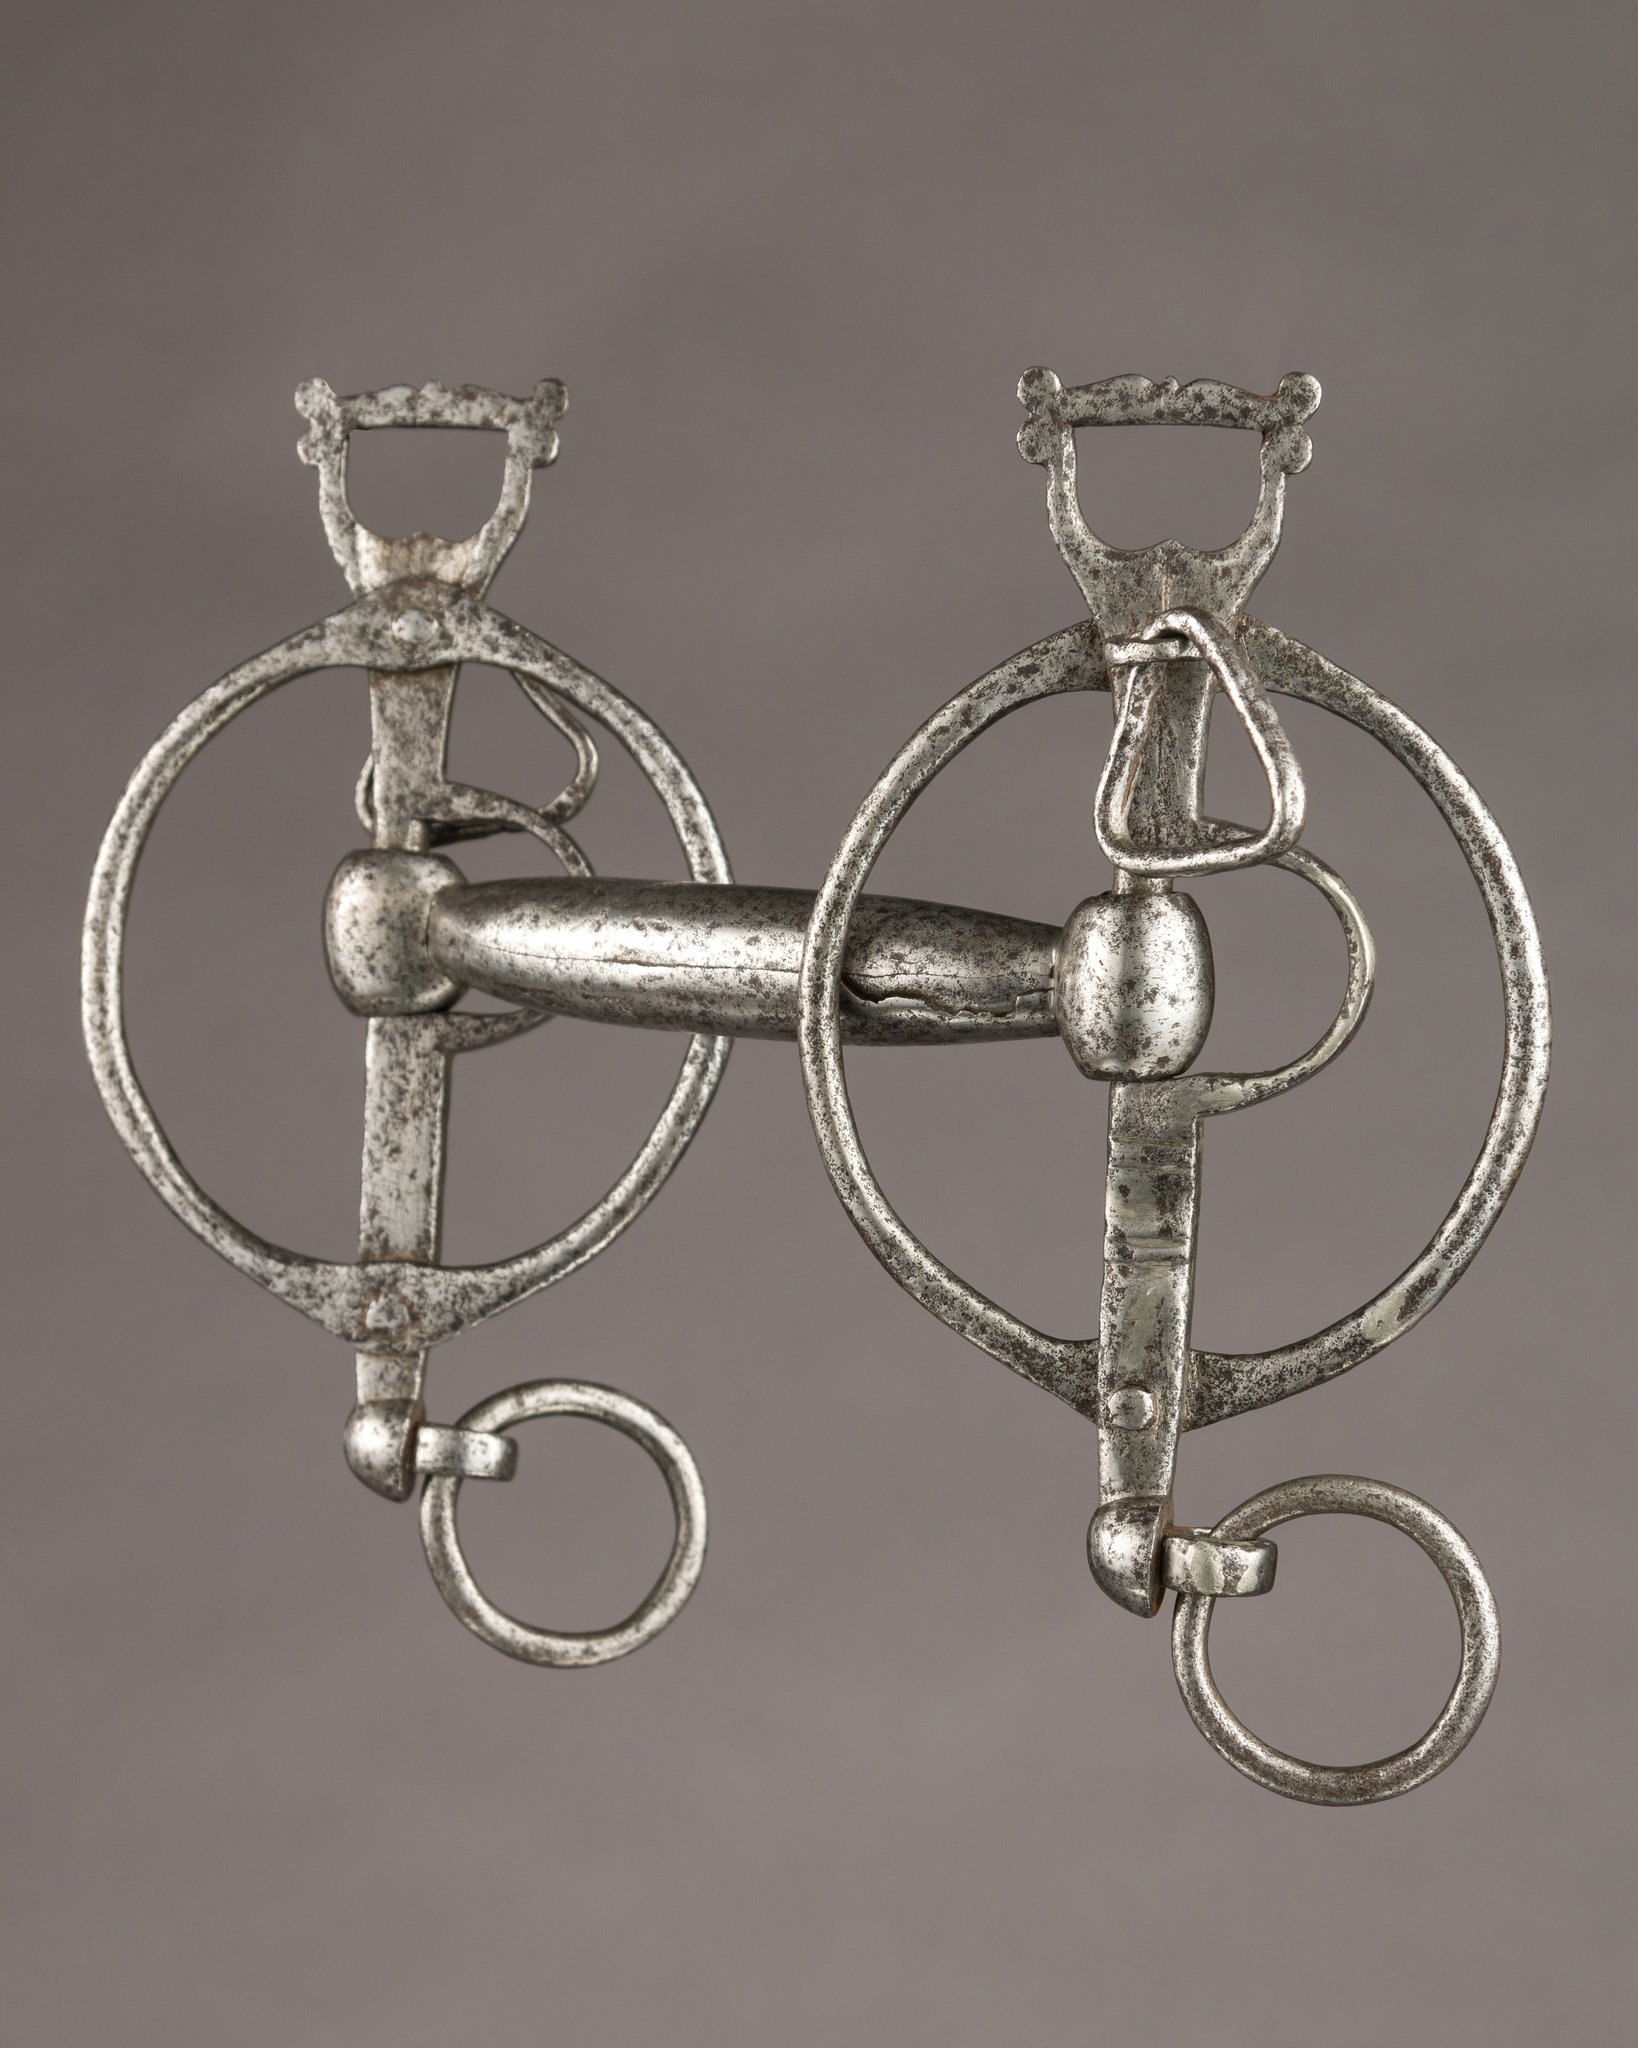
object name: bit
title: Curb Bit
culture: german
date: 1701-1800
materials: metal alloy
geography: germany